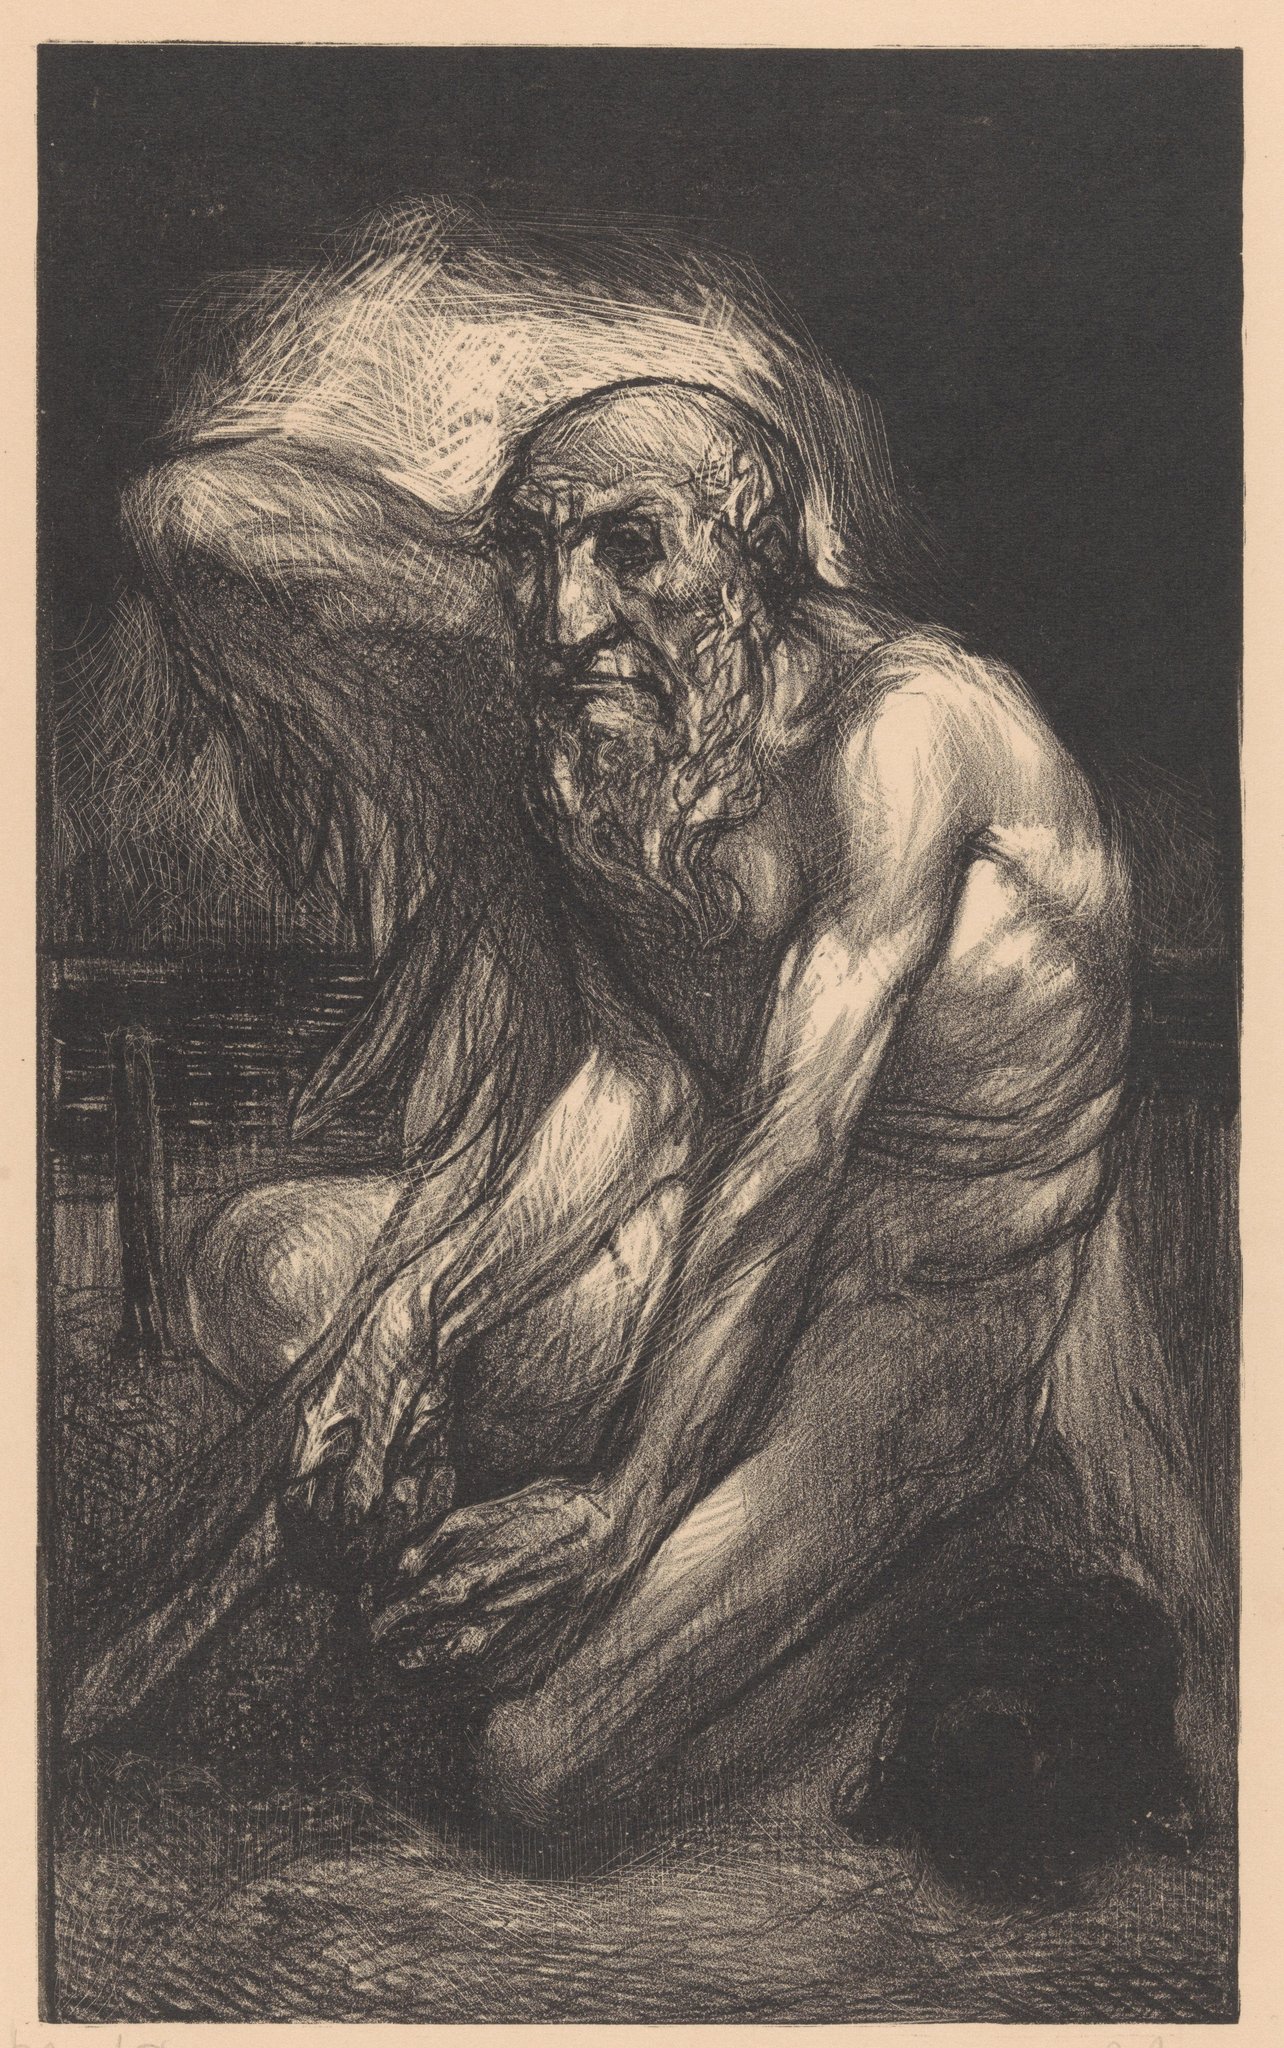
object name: print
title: Zittende, bebaarde man met vleugels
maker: johannes josephus aarts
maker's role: draughtsman, print maker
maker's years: 1871-1934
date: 1927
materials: paper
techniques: lithograph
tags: beard, angels, man (showing himself) undressed, quasi-nude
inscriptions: collector's mark: Lugt 2228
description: Deze prent is mogelijk geïnspireerd op de dichtbundel 'Les Apparus dans mes chemins' van Émile Verhaeren uit 1891.